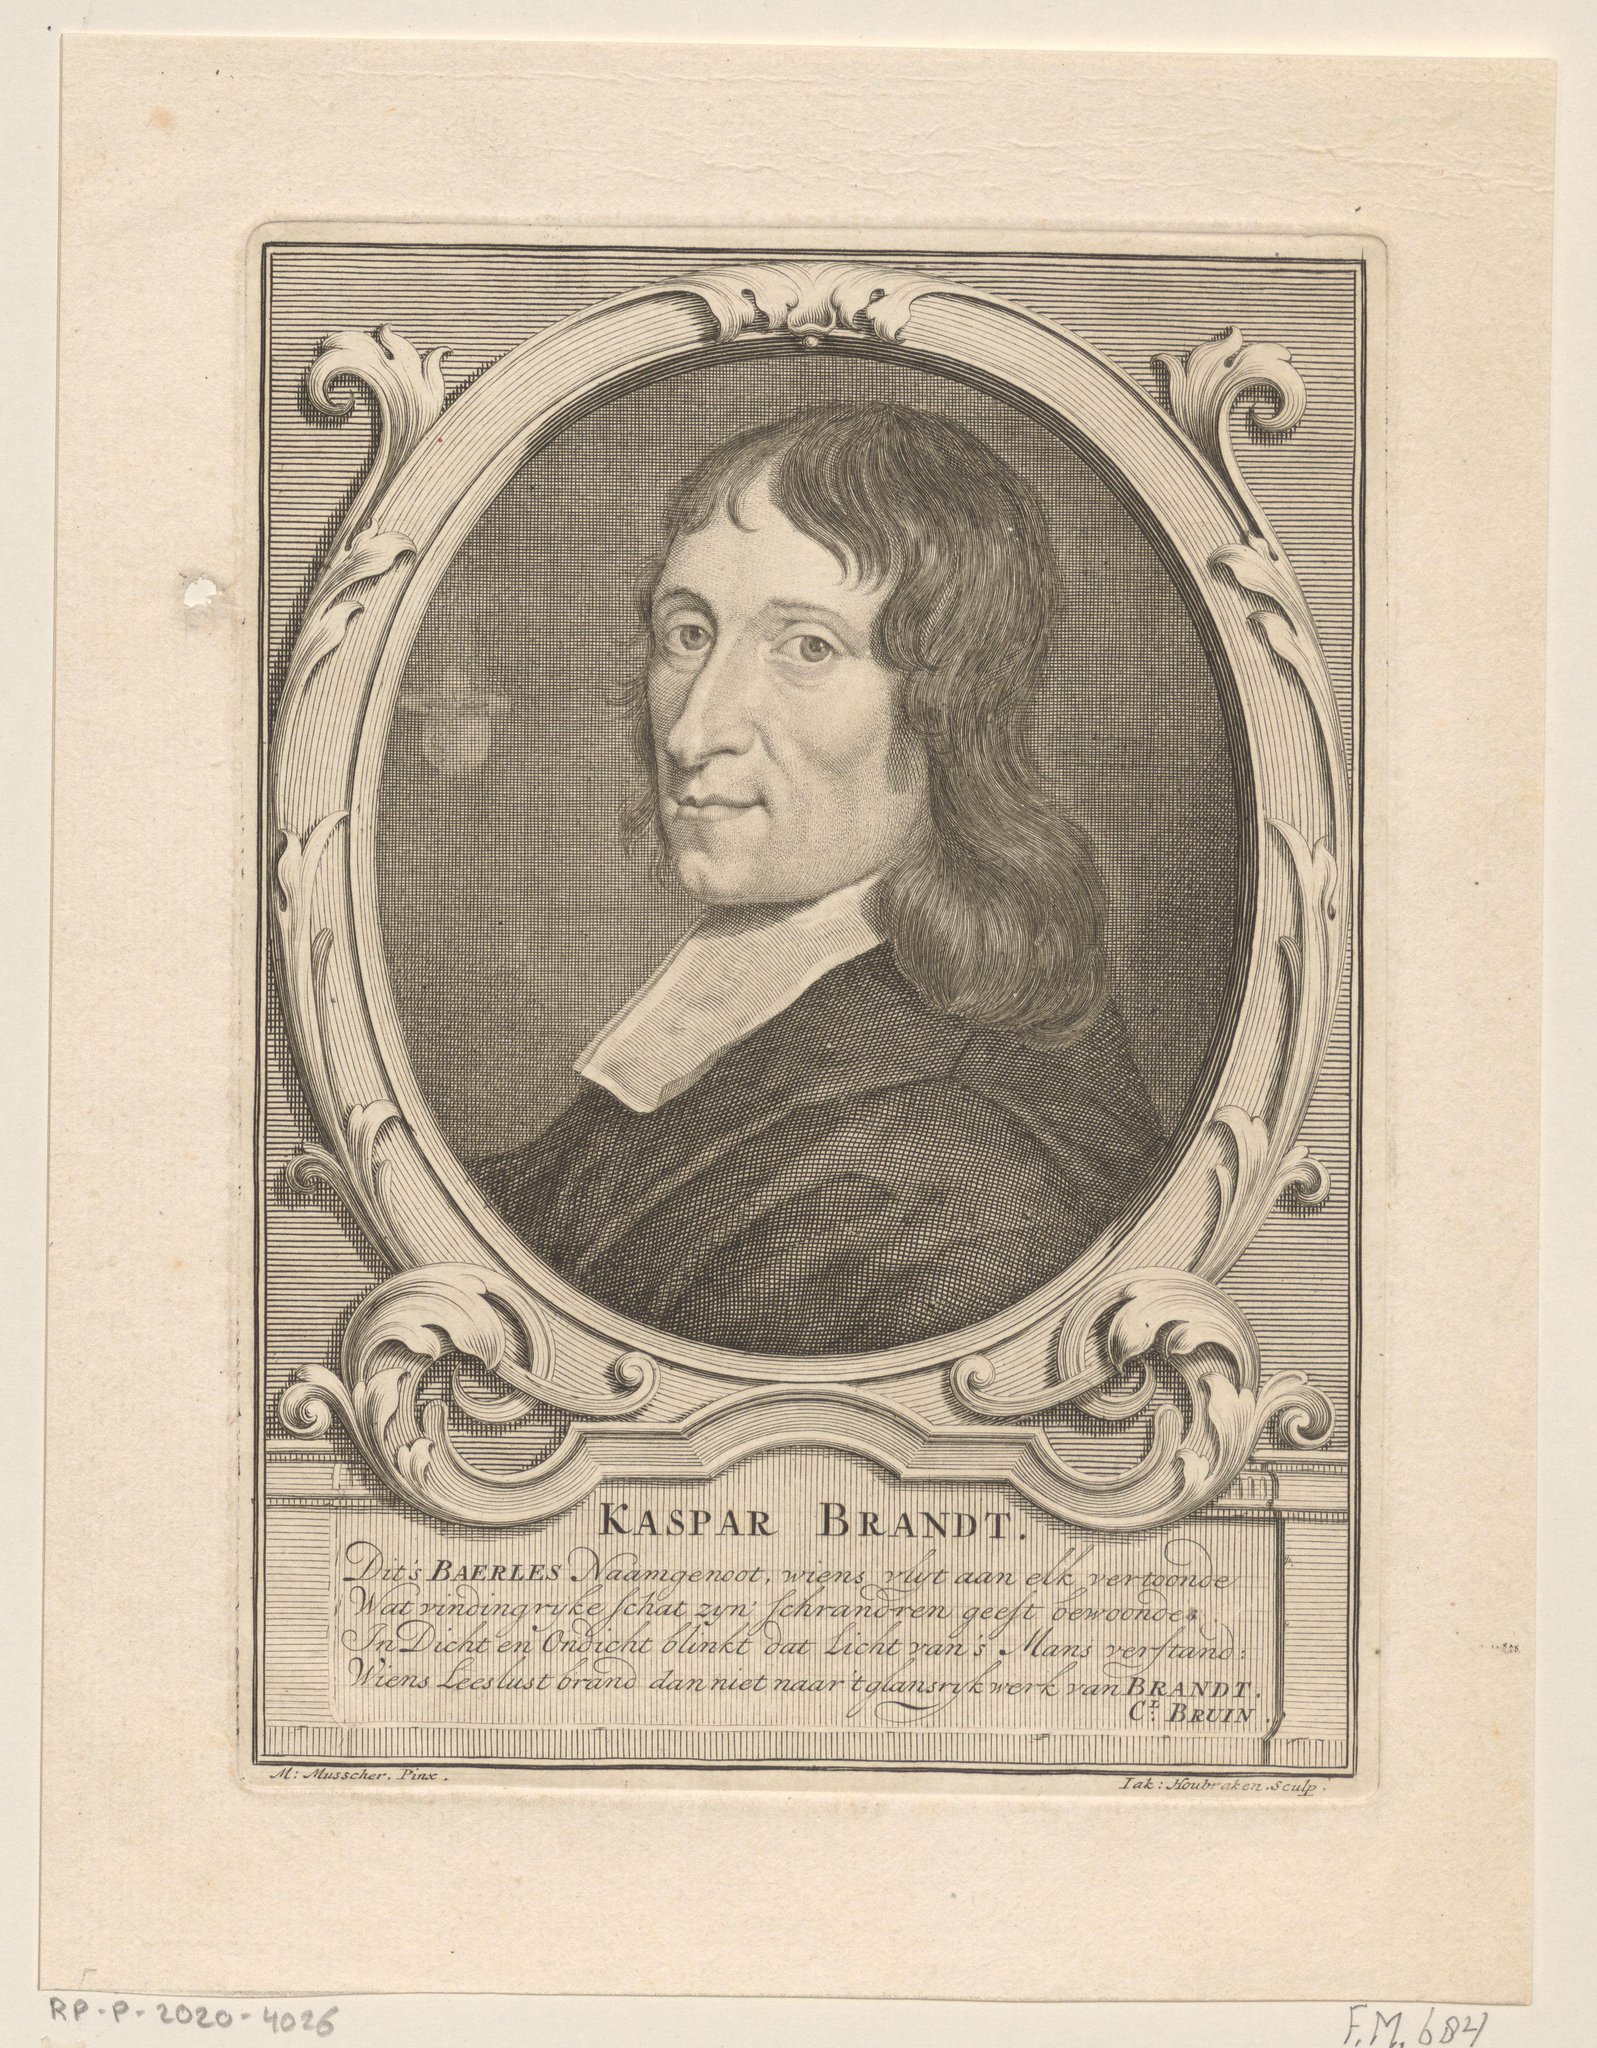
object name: print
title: Portret van Kaspar Brandt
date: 1710-1780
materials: paper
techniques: engraving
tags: historical persons